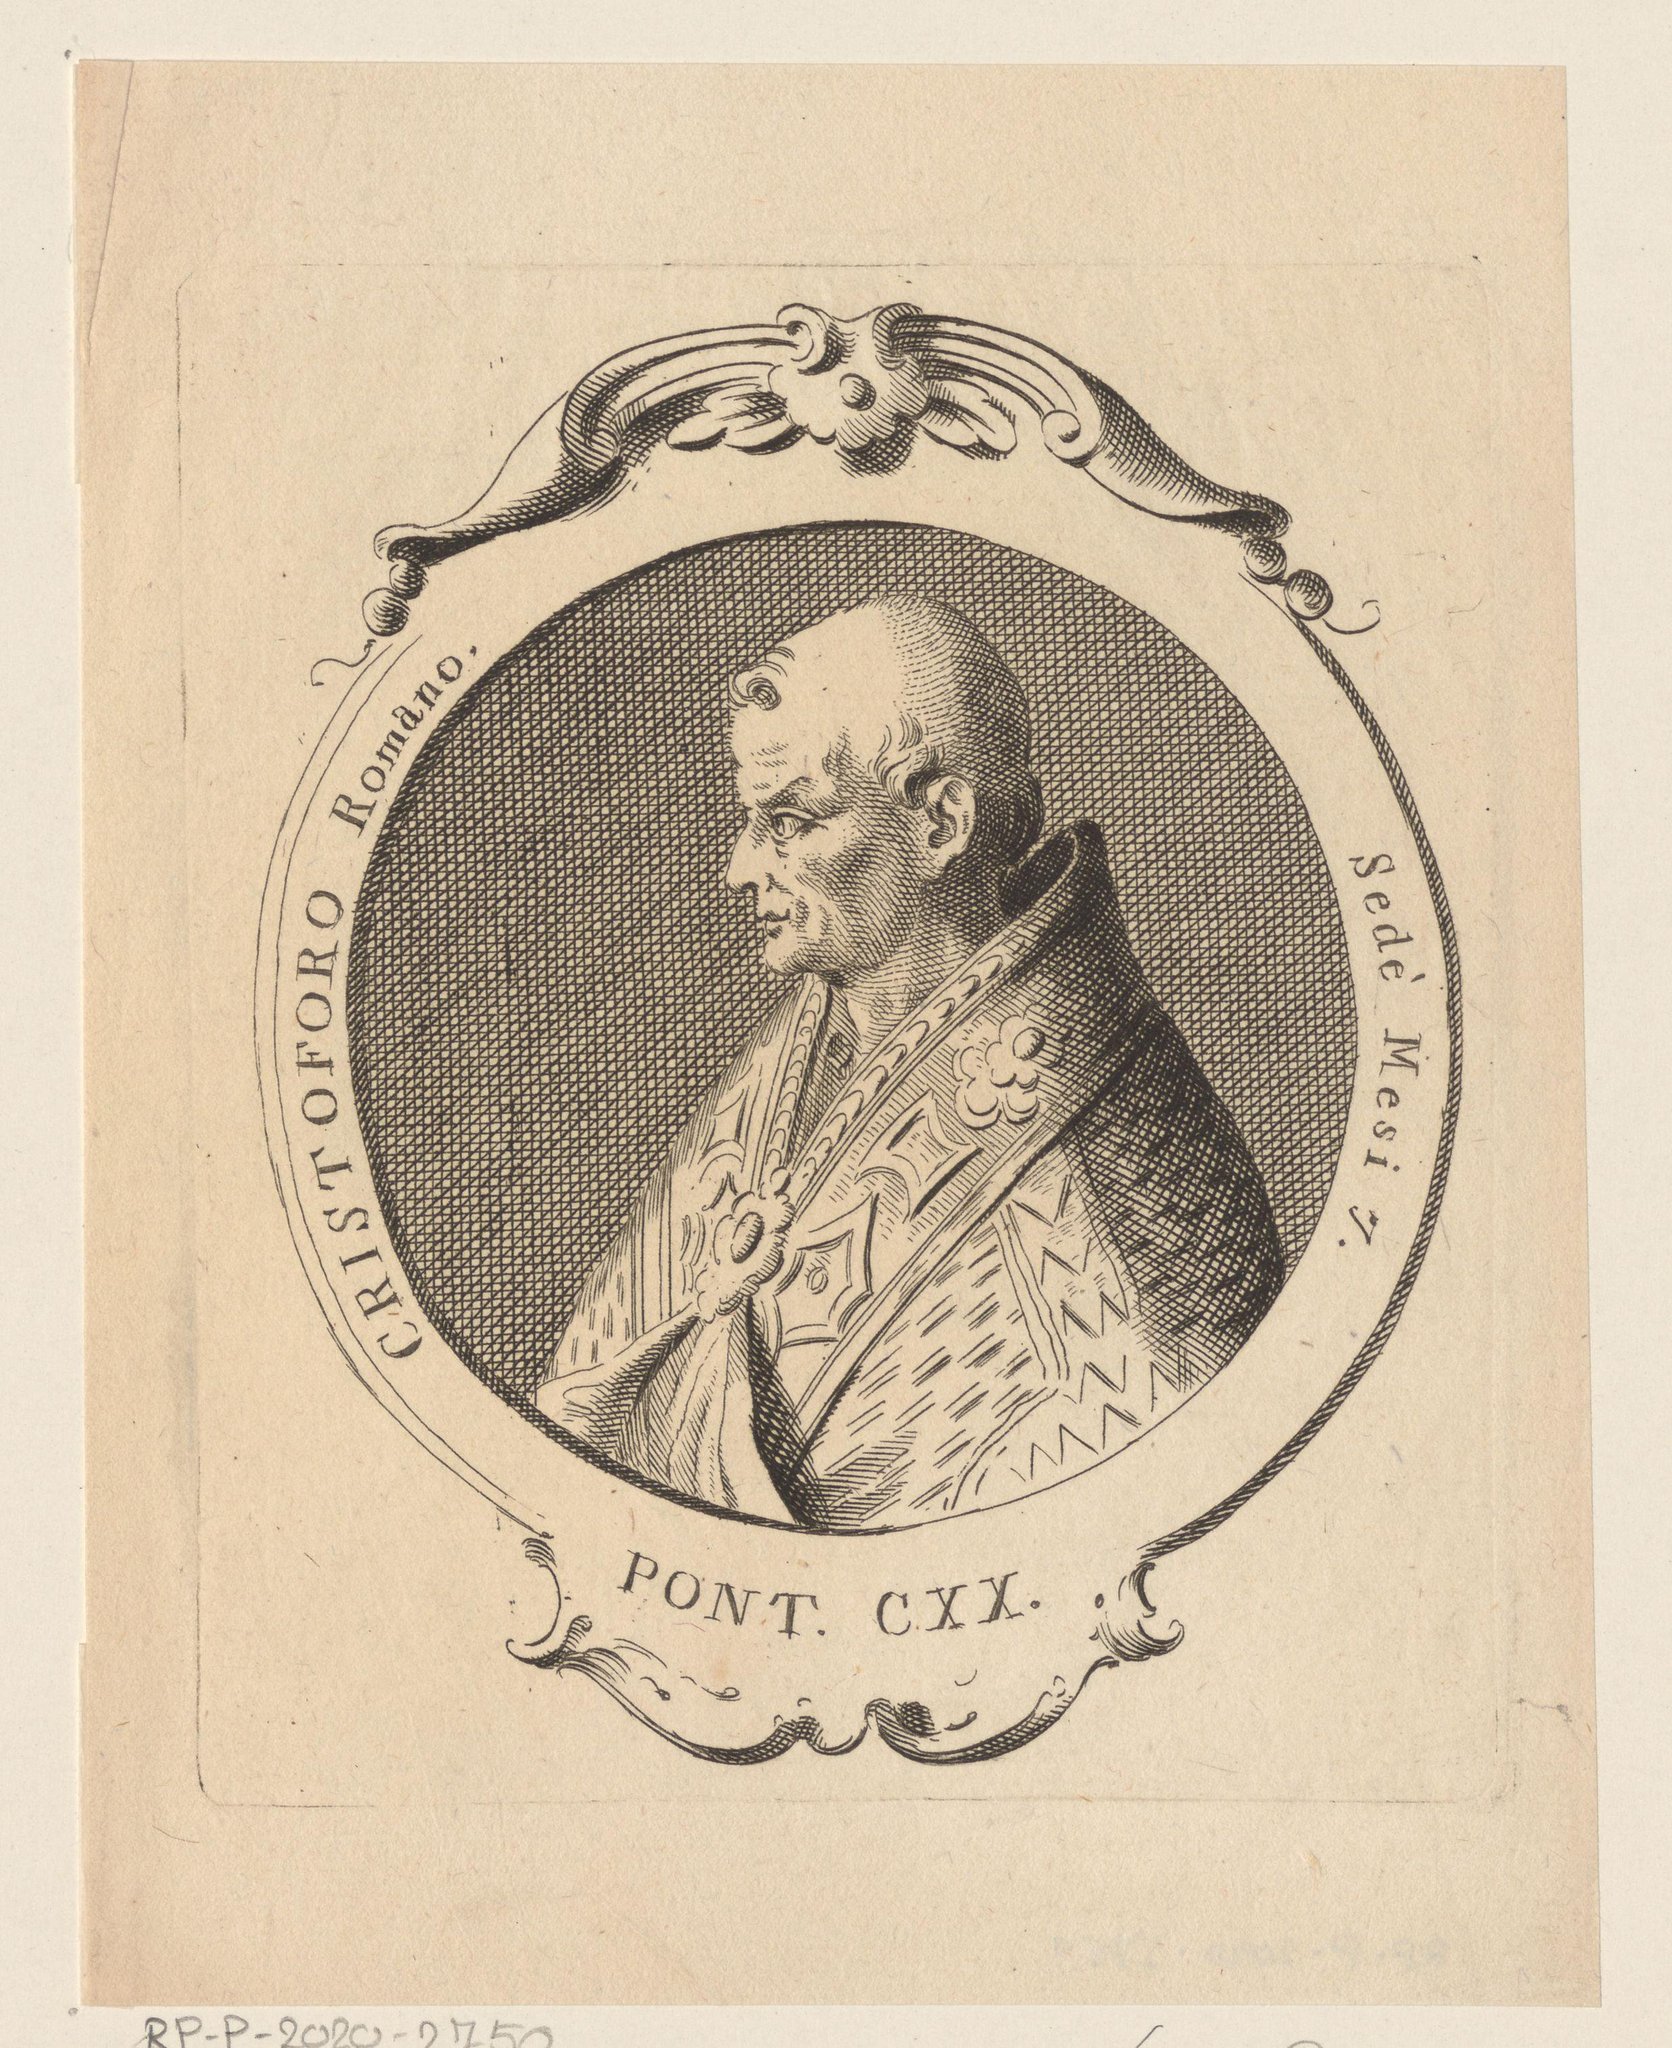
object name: print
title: Portret van tegenpaus Christoforus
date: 1775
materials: paper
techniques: engraving, etching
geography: bassano del grappa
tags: historical persons, pope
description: Prent waarschijnlijk uit: Effigies Romanorum pontificum a S. Petro ad Pium VI. feliciter regnantem (...). 2 dln. Venetië en Bassano del Grappa: Giuseppe Remondini, 1775.